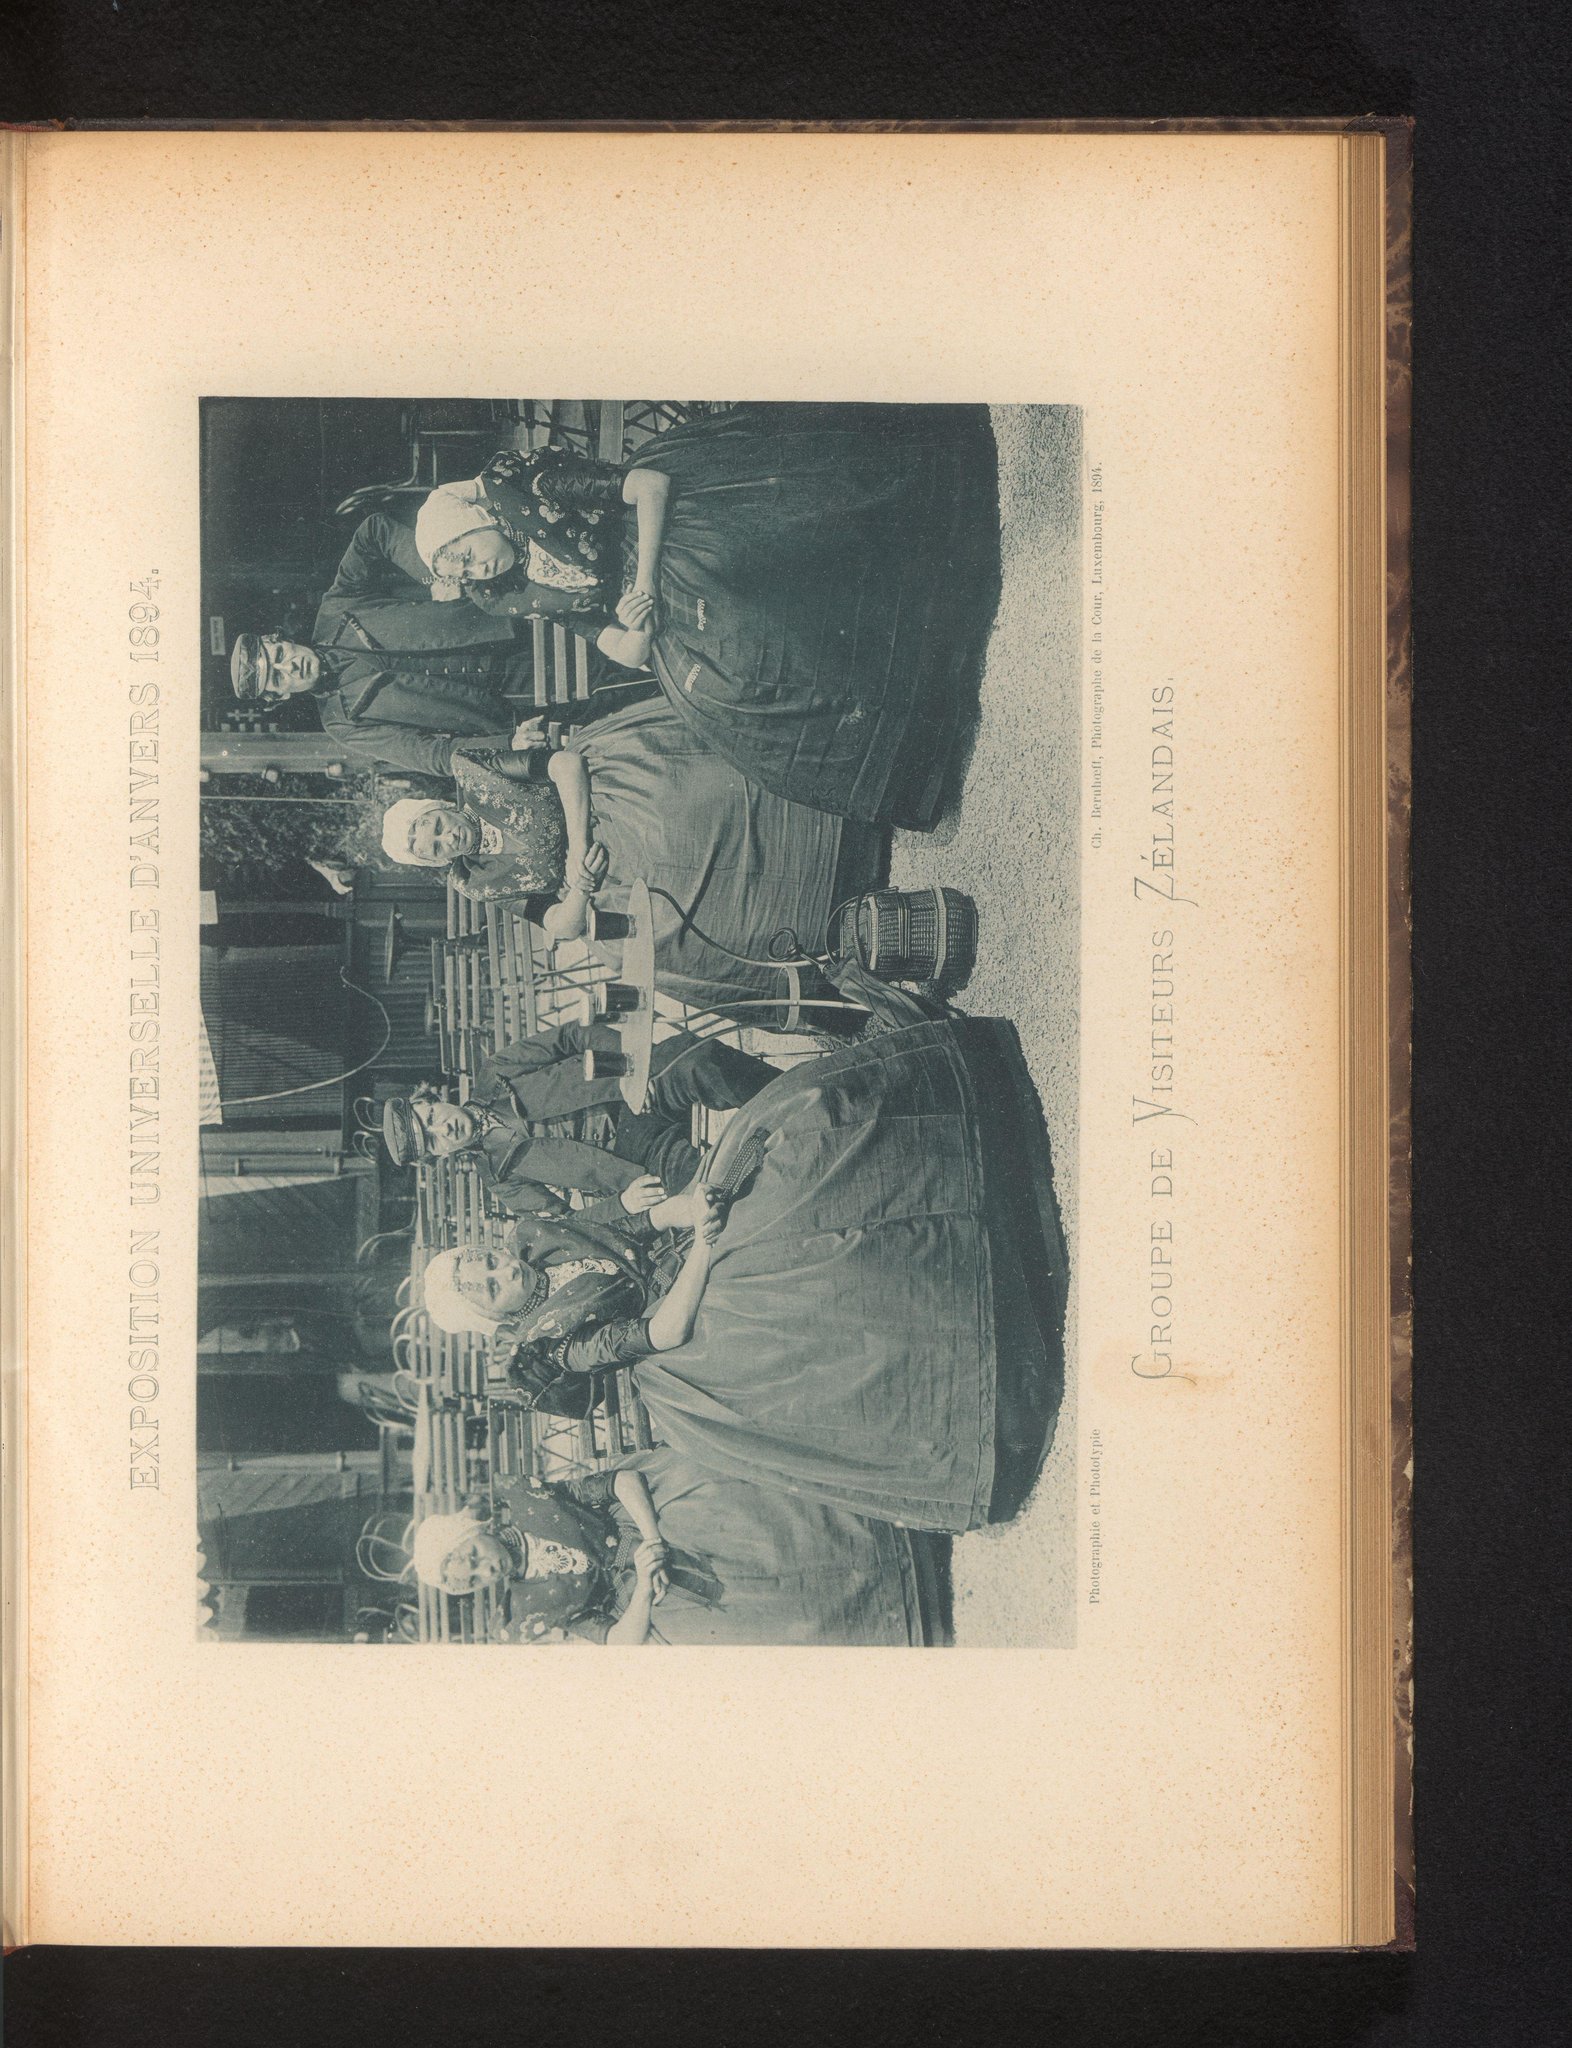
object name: photomechanical print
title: Groep bezoekers uit Zeeland op de Wereldtentoonstelling van Antwerpen in 1894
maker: charles bernhoeft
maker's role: publisher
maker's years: 1859-1933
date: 1894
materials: paper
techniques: photograph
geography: luxembourg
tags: world fair, world exhibition, anonymous historical persons portrayed in a group, in a group-portrait, antwerp